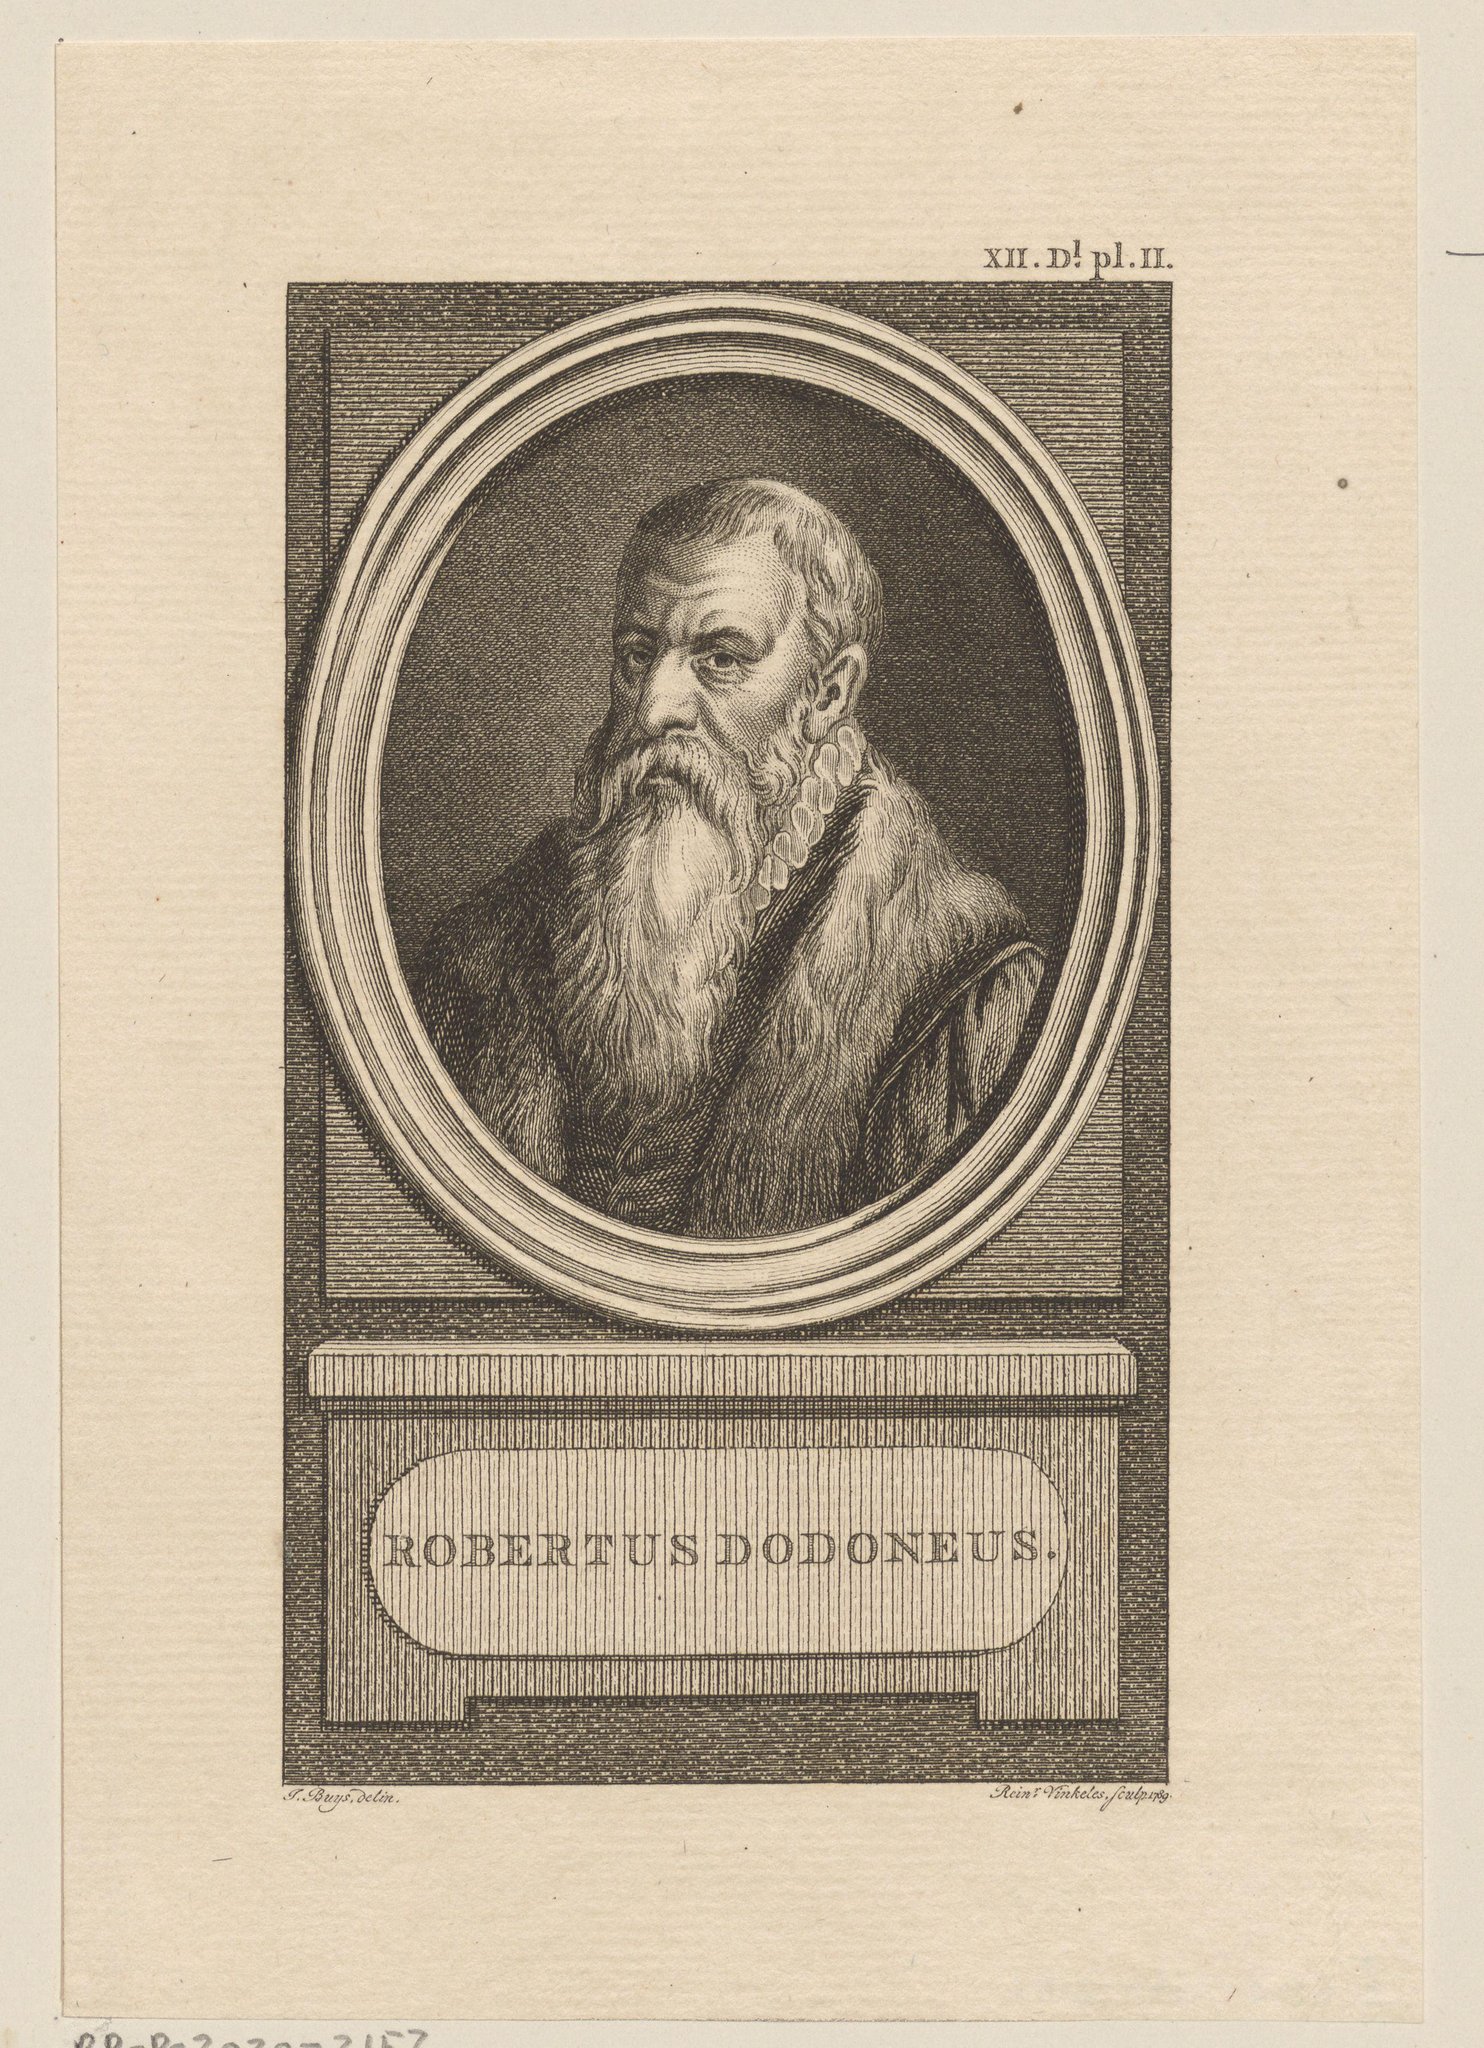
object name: print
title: Portret van Rembertus Dodonaeus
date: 1789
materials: paper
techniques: etching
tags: mechelen, leiden, rembertus dodonaeus, historical persons, physician, doctor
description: Prent mogelijk uit: Kok, Jacobus. Vaderlandsch woordenboek (...). 35 dln. Amsterdam: Johannes Allart, 1785-1796, dl. 12.